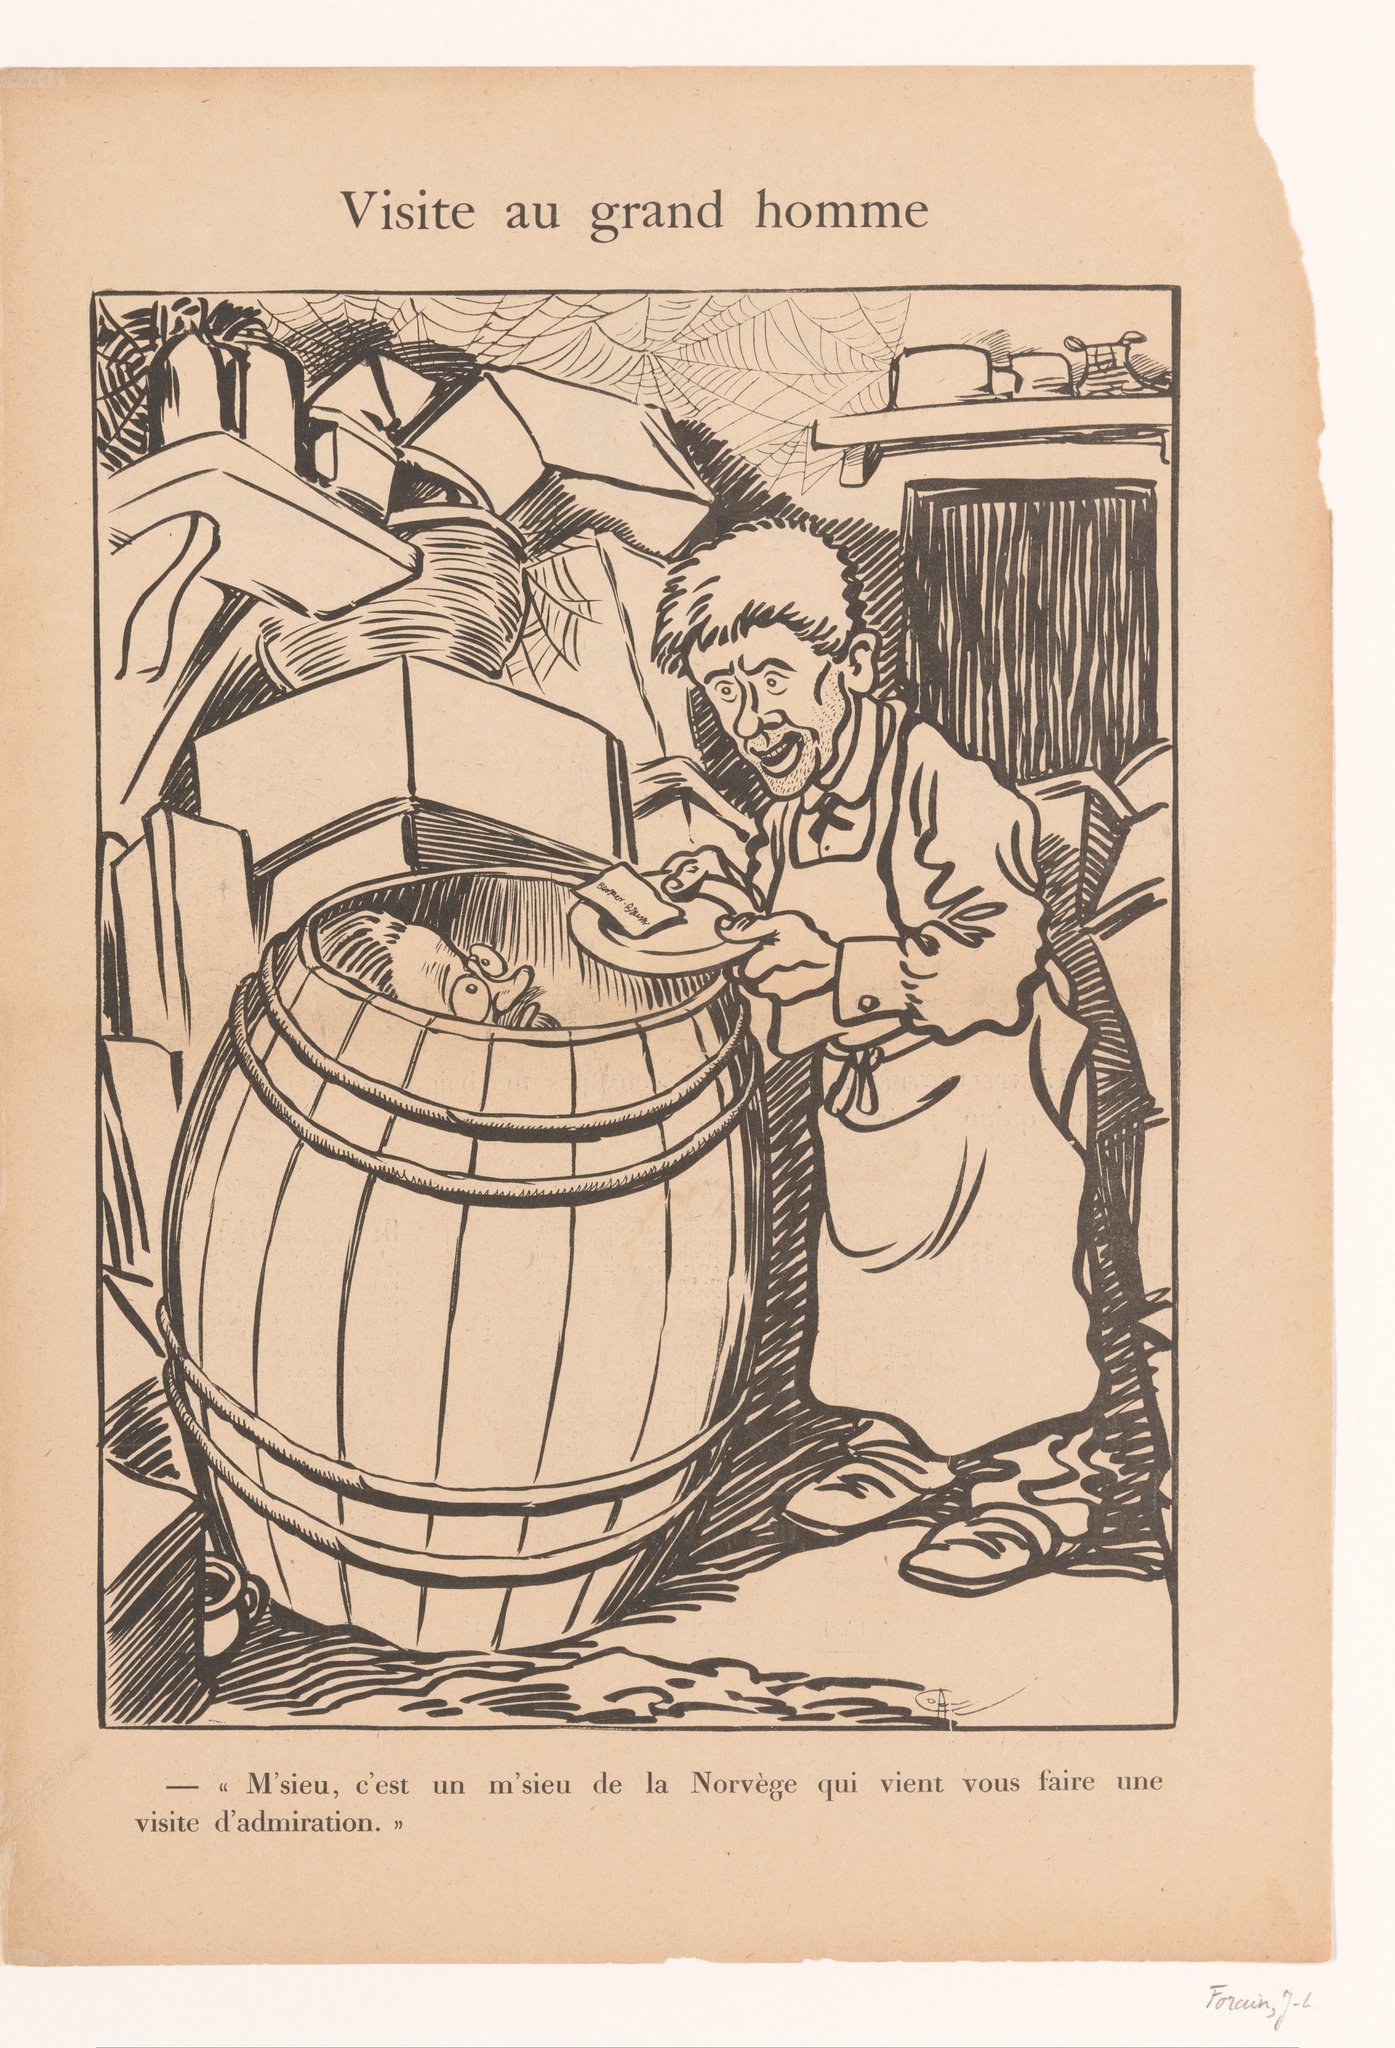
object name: print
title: Karikatuur van Émile Zola die een brief ontvangt van een Noorse bewonderaar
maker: caran dache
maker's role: draughtsman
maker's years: 1859-1909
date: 1898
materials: paper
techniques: lithograph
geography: paris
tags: emile zola, caricatures (human types), historical persons, political caricatures and satires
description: Prent gebruikt voor: Psst...!, nr. 29, 20 augustus 1898. Psst..! was een politieke weekkrant met antisemitische en anti-Dreyfus cartoons.